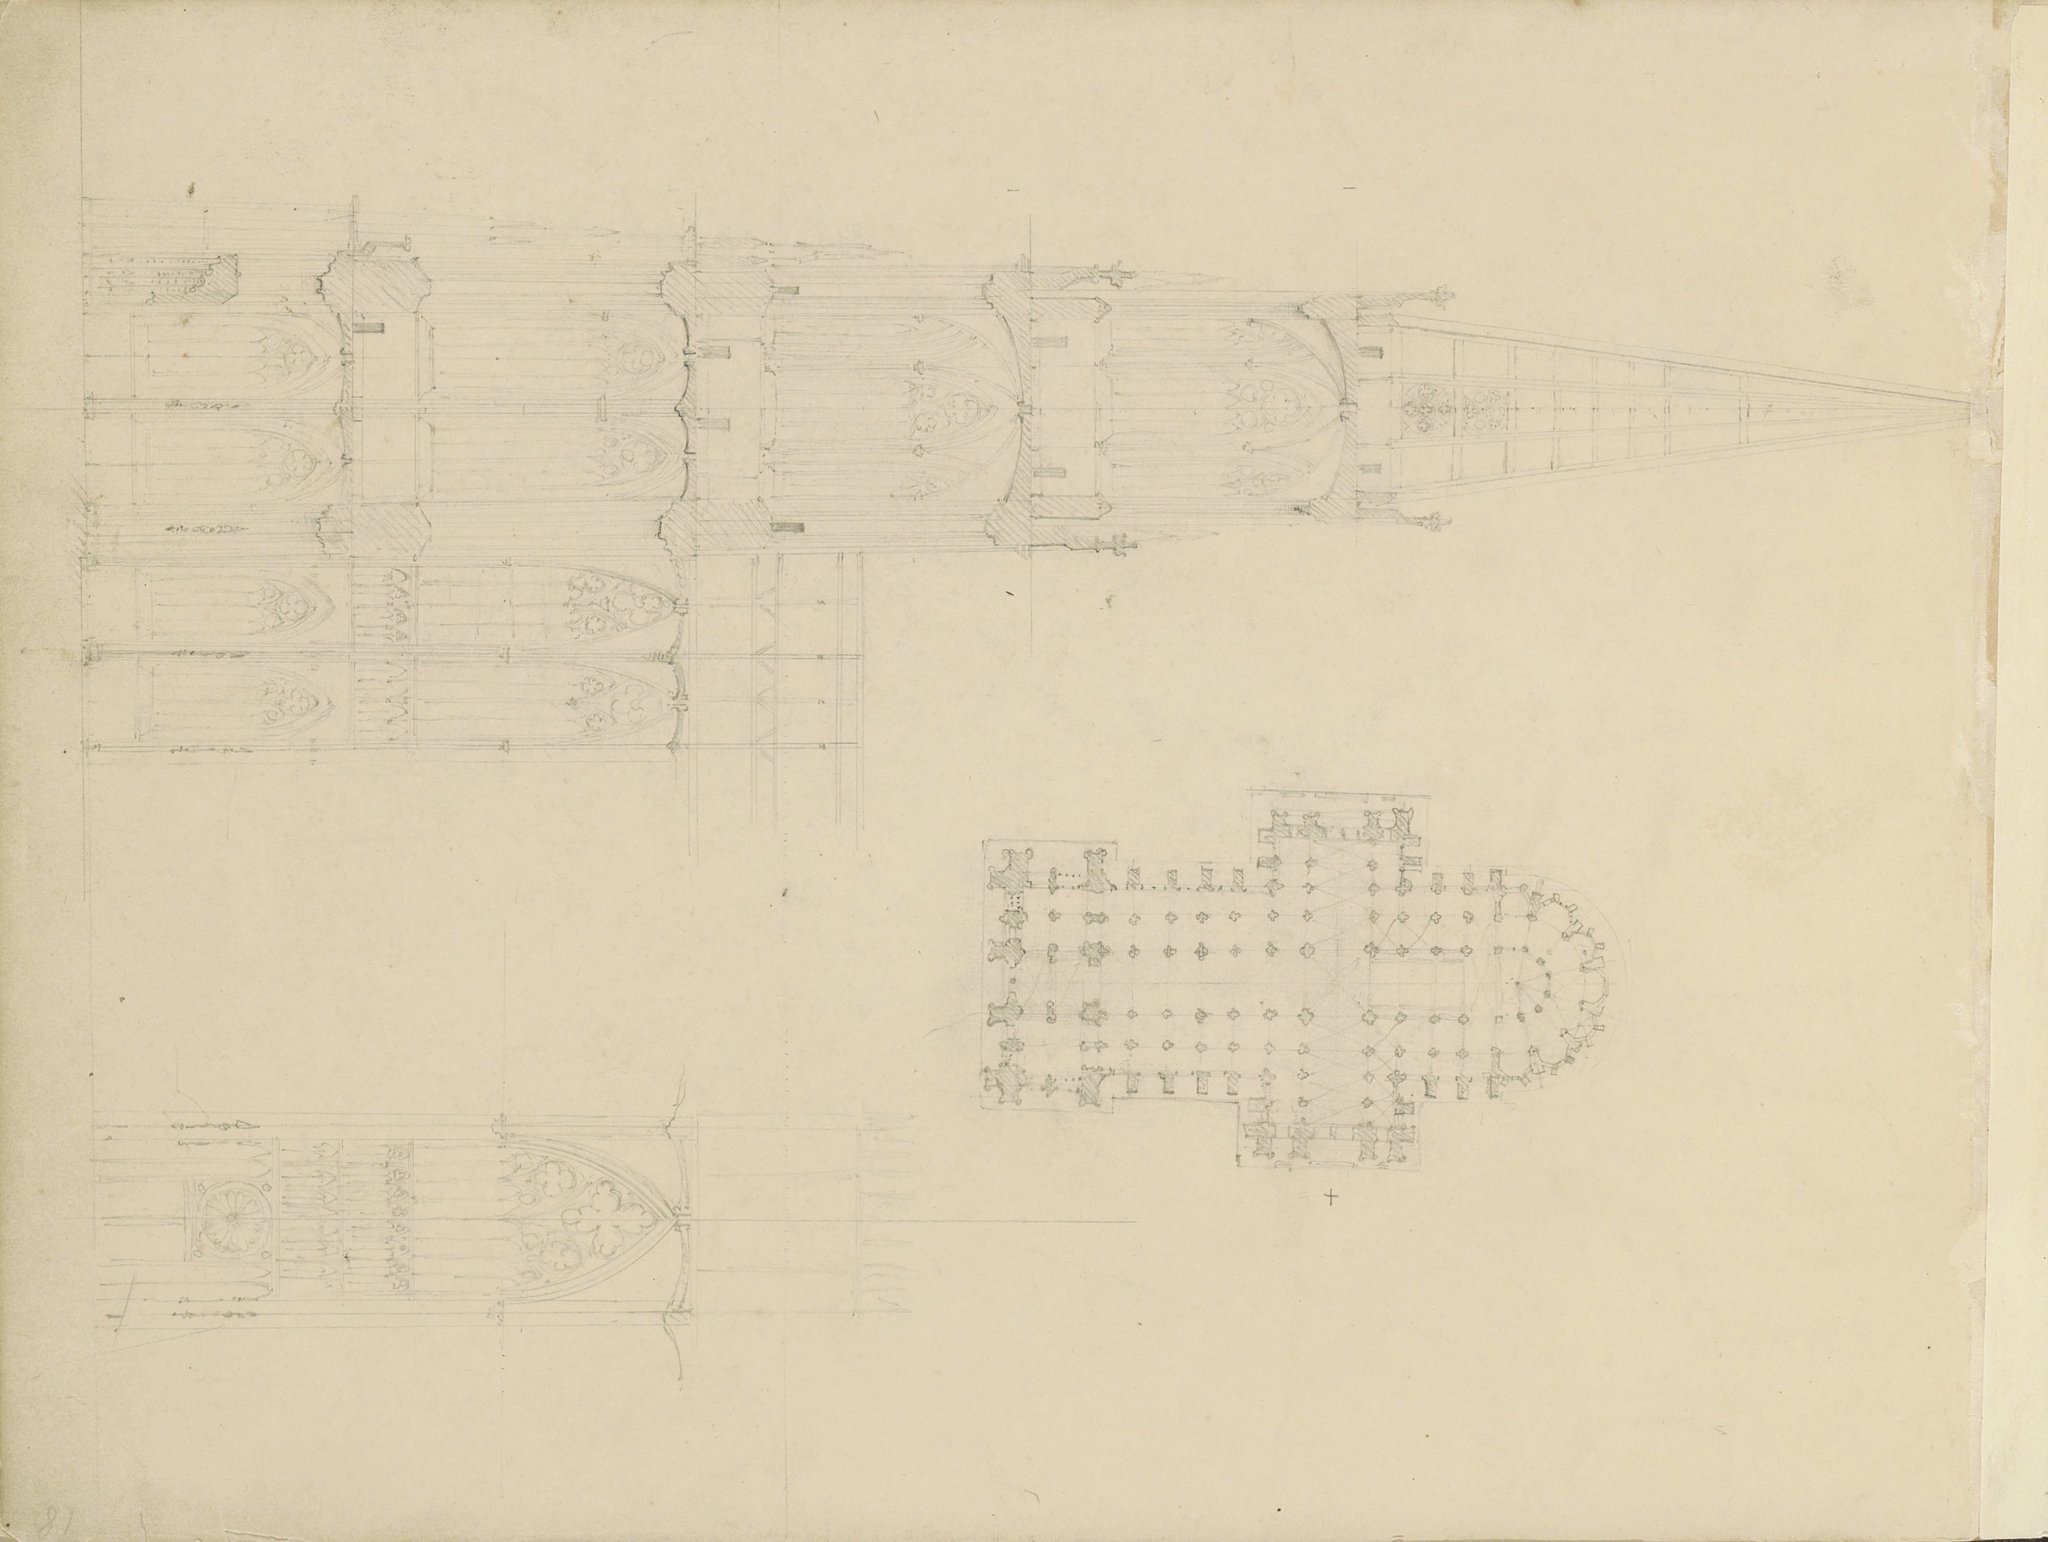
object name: sketchbook leaf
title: Zijaanzicht, plattegrond en portaal van een gotische kathedraal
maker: pierre joseph hubert cuypers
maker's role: draughtsman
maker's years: 1827-1921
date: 1850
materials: paper, pencil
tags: parts of church exterior and annexes: portal, parts of church exterior and annexes: façade, plan ~ architecture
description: Blad 15 verso uit een schetsboek met 37 bladen.